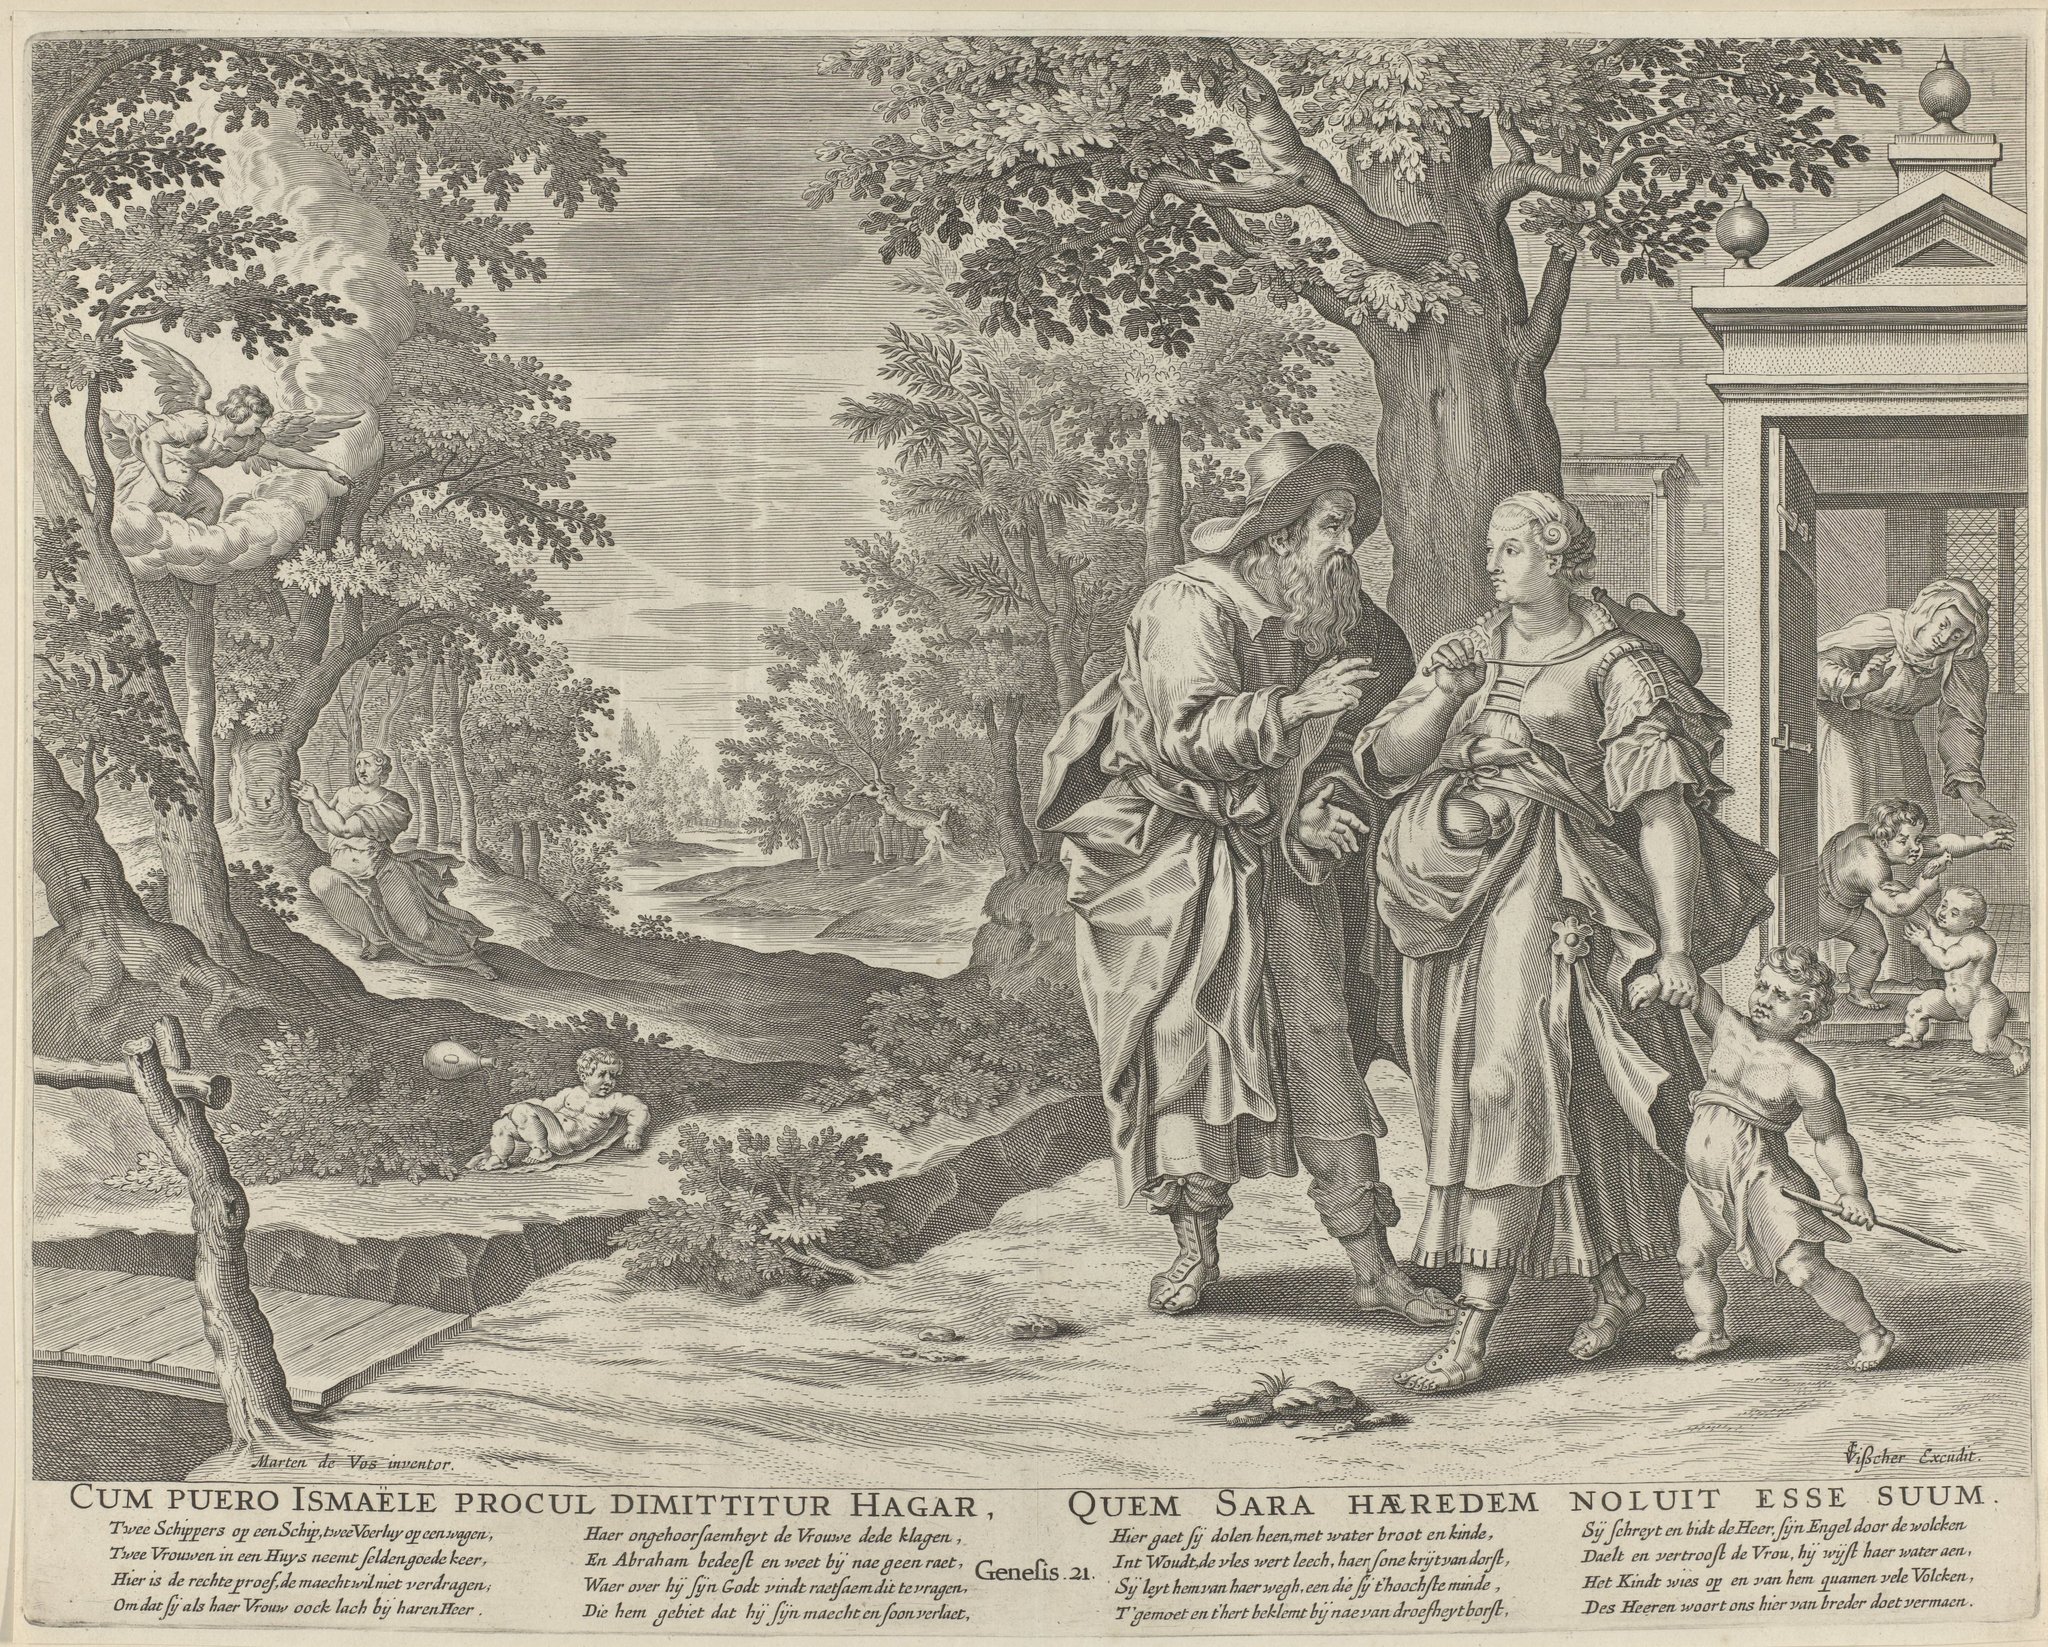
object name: print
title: Cum puero Ismaële procul dimittitur Hagar (...)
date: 1630-1652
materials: paper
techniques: engraving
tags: abraham provides hagar and ishmael with bread and a jug of water, an angel appears and reveals a well of water to hagar, hagar sits weeping after having put ishmael under a bush to die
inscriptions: collector's mark: Lugt 2228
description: De Amsterdamse uitgever Claes Jansz. Visscher (II) produceerde vanaf de jaren ’30 van de zeventiende eeuw grote Bijbelse prenten op zogenaamd royaal-formaat papier (ca. 480 x 580 mm). Na zijn dood in 1652 zette zijn zoon Nicolaes Visscher (I) het bedrijf voort en zo ook de uitgave van Royaalbijbelprenten. Toen Nicolaes in 1679 overleed nam zijn zoon Nicolaes Visscher (II) het bedrijf over en gaf kort hierna, omstreeks 1680, een fondslijst uit. Hierin worden 130 prenten met Bijbelse voorstellingen op royaalpapier beschreven (zie documentatie J. van der Waals). Complete prentbijbels op royaal-formaat werden door vader en zoon Nicolaes Visscher uitgegeven onder de titel Historiae Sacrae Veteris et Novi Testamenti. De bladen werden echter ook los verkocht en konden worden gecombineerd met Royaalbijbel-prenten van andere uitgevers. Verschillende Amsterdamse uitgevers brachten namelijk ook bijbelprenten op royaal-formaat uit, onder wie Clement de Jonghe en Cornelis Danckerts. De door de firma Visscher uitgegeven prenten zijn veelal vervaardigd door anonieme prentmakers naar voorbeeld van verschillende zestiende- en zeventiende-eeuwse Bijbelse prenten en prentreeksen. Veelal moesten de composities worden aangepast aan het grotere en langgerekte royaal-formaat. Daarnaast zijn er ook grote bladen van bekende prentmakers zoals Jan van Londerseel, Pieter Nolpe, Jacques de Gheyn (II) en Jan Harmensz. Muller opgenomen in de categorie ‘Bybelsche Figuren, op Royaal-bladen’ in de fondslijst van Visscher. Prent mogelijk gebruikt in: Historiae Sacrae Veteris et Novi Testamenti (Royaalbijbel). Amsterdam: Nicolaes Visscher (I) en (II), [1652-1702]. In de fondslijst van Nicolaes Visscher II (ca. 1680) is het onderwerp van deze prent onder de titel 'Bybelsche Figuren, op Royaal-bladen. bestaande uyt de volgende historien.' als volgt genummerd: 11.